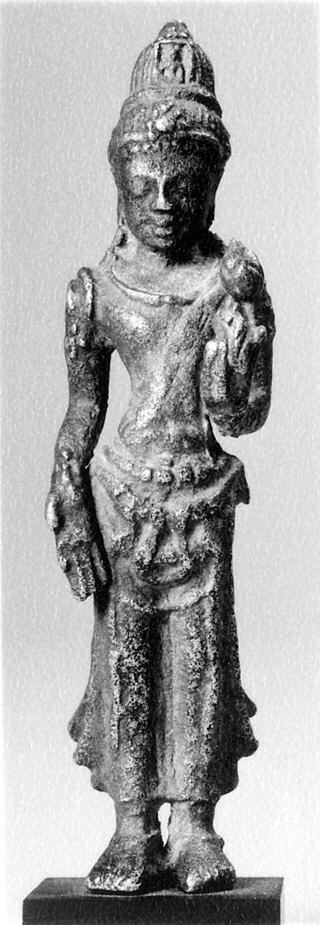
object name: figure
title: Standing Avalokiteshvara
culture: indonesian, sumatran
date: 901-1100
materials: bronze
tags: buddhism,avalokiteshvara,bodhisattvas